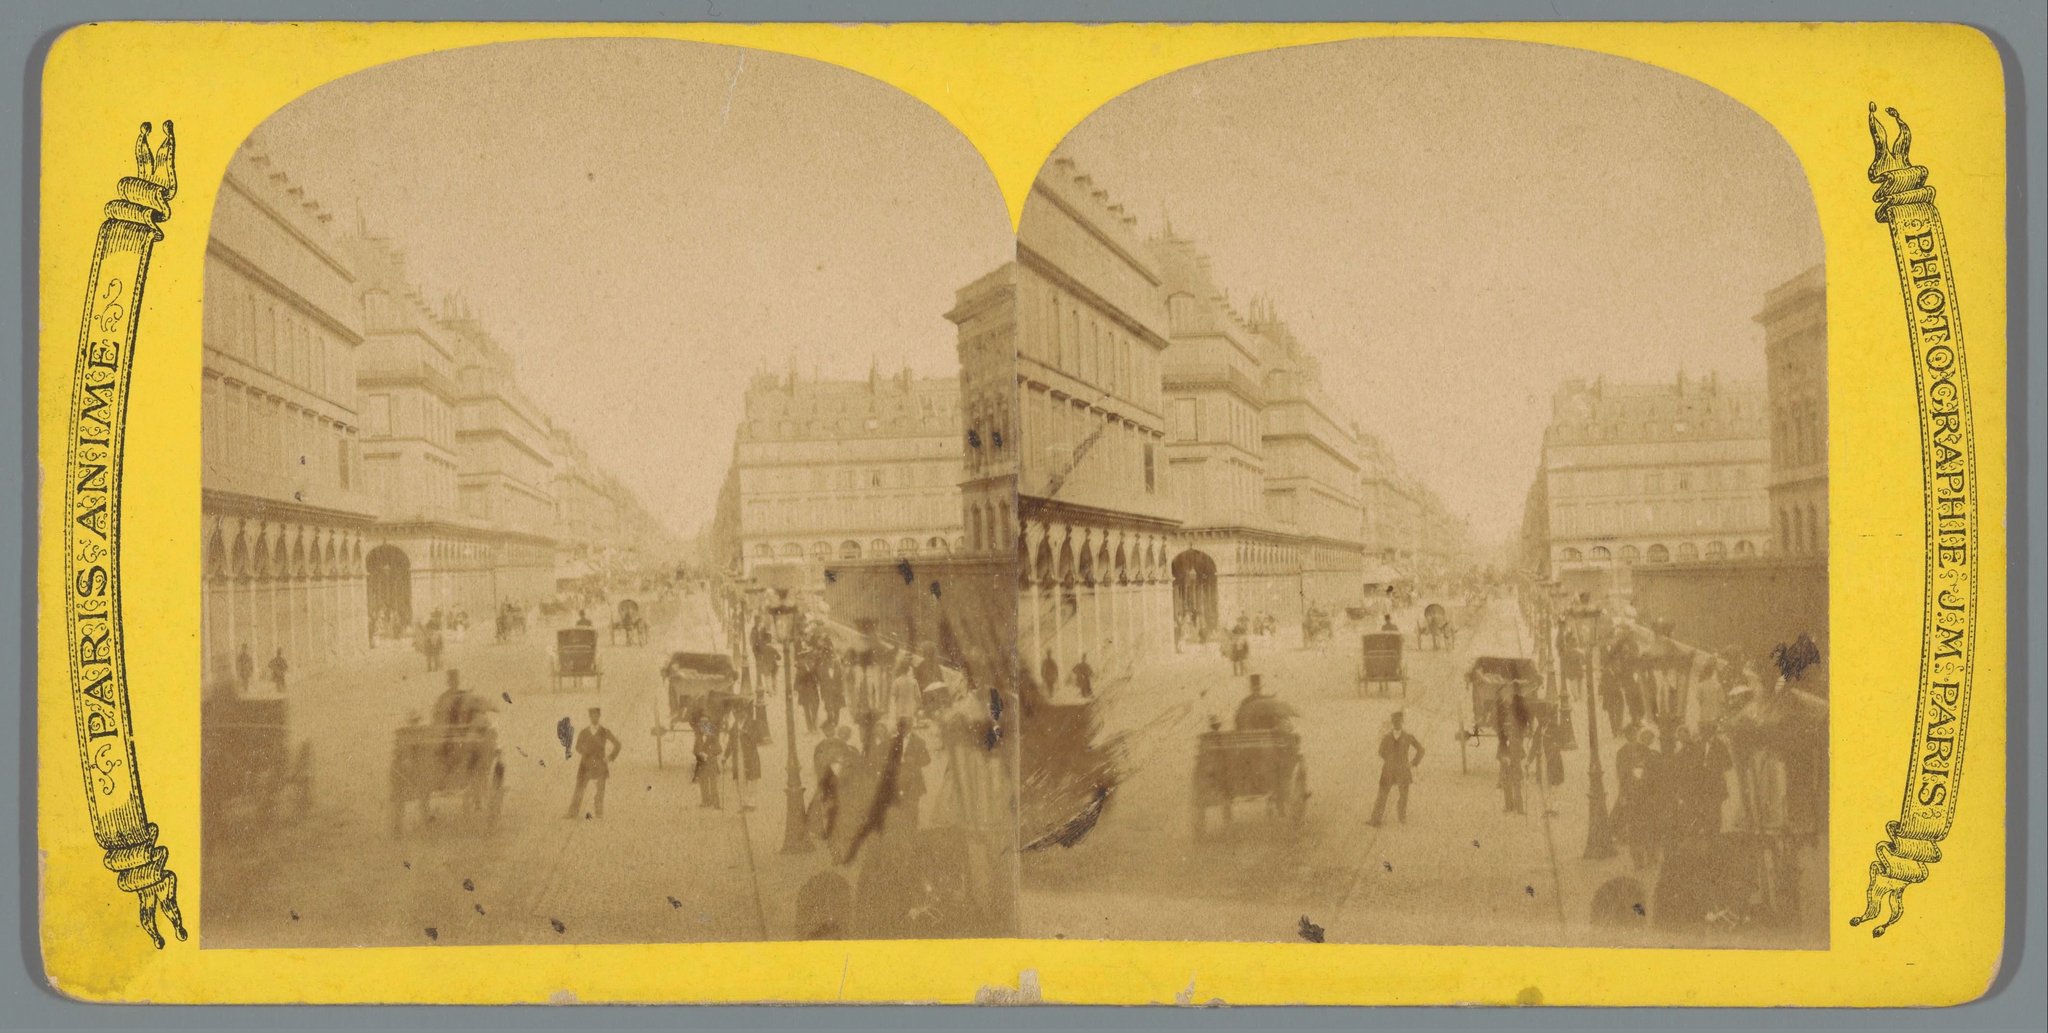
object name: stereograph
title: Gezicht op de Rue de Rivoli in Parijs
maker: jules marinier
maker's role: publisher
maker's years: 1823-1896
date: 1850-1880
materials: cardboard, photographic support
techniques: albumen print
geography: paris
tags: two-wheeled, animal-drawn vehicle, street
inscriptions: inscription: ‘Rue de Rivoli Paris’